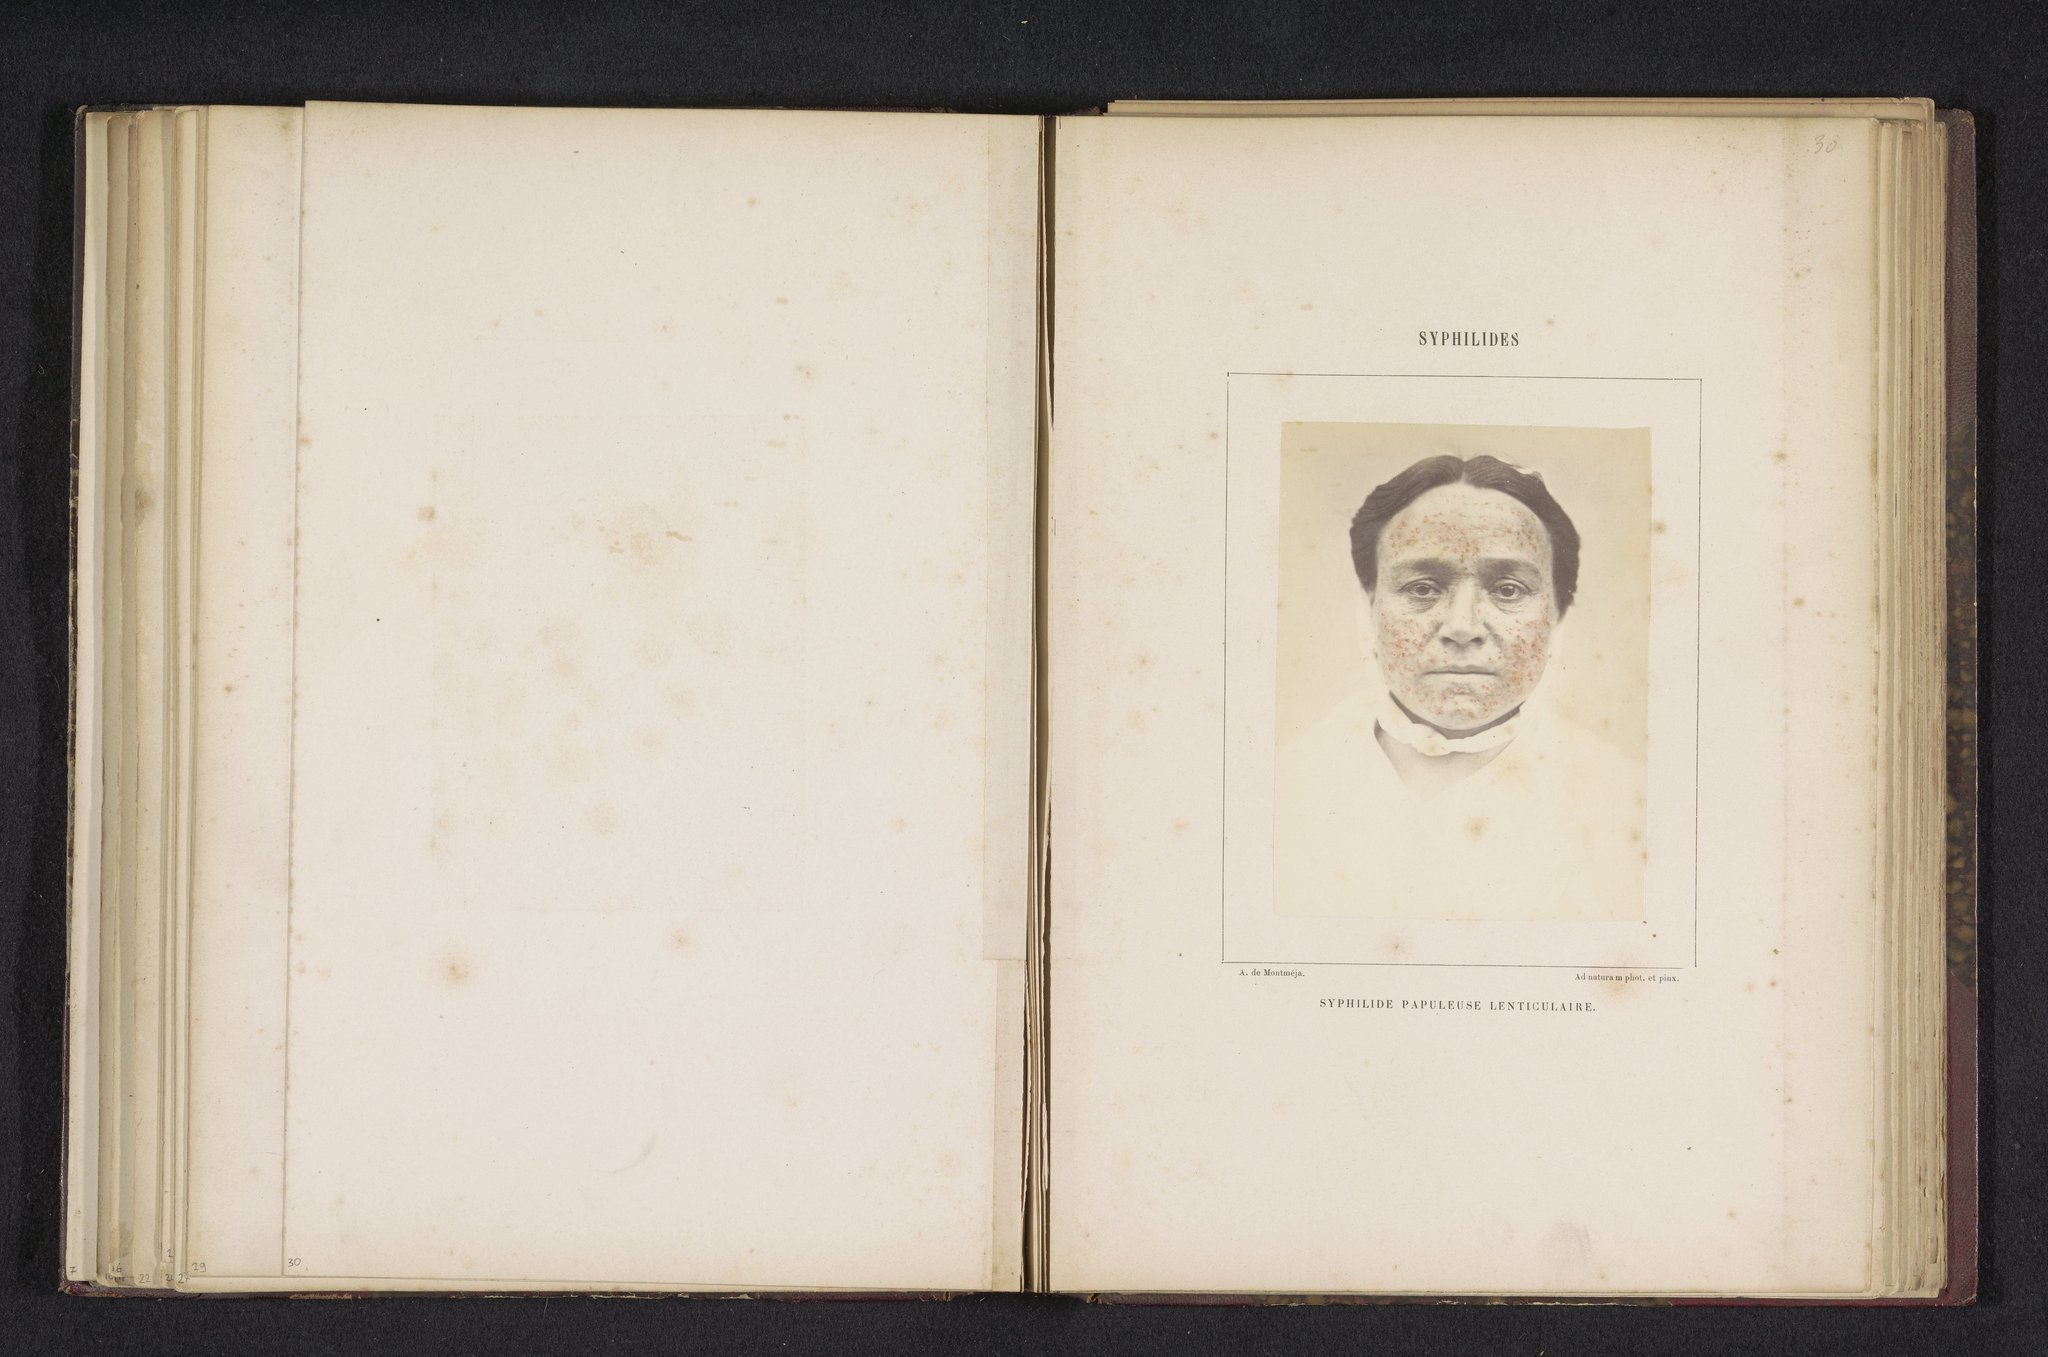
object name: page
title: Huiduitslag veroorzaakt door syfilis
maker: a. de montméja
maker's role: arts, fotograaf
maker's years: 1841-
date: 1860-1868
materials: photographic support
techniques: albumen print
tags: skin and venereal diseases: syphilis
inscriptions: inscription: ‘Ad naturam phot. et pinx.’, inscription: ‘Syphilides’, number: ‘30’